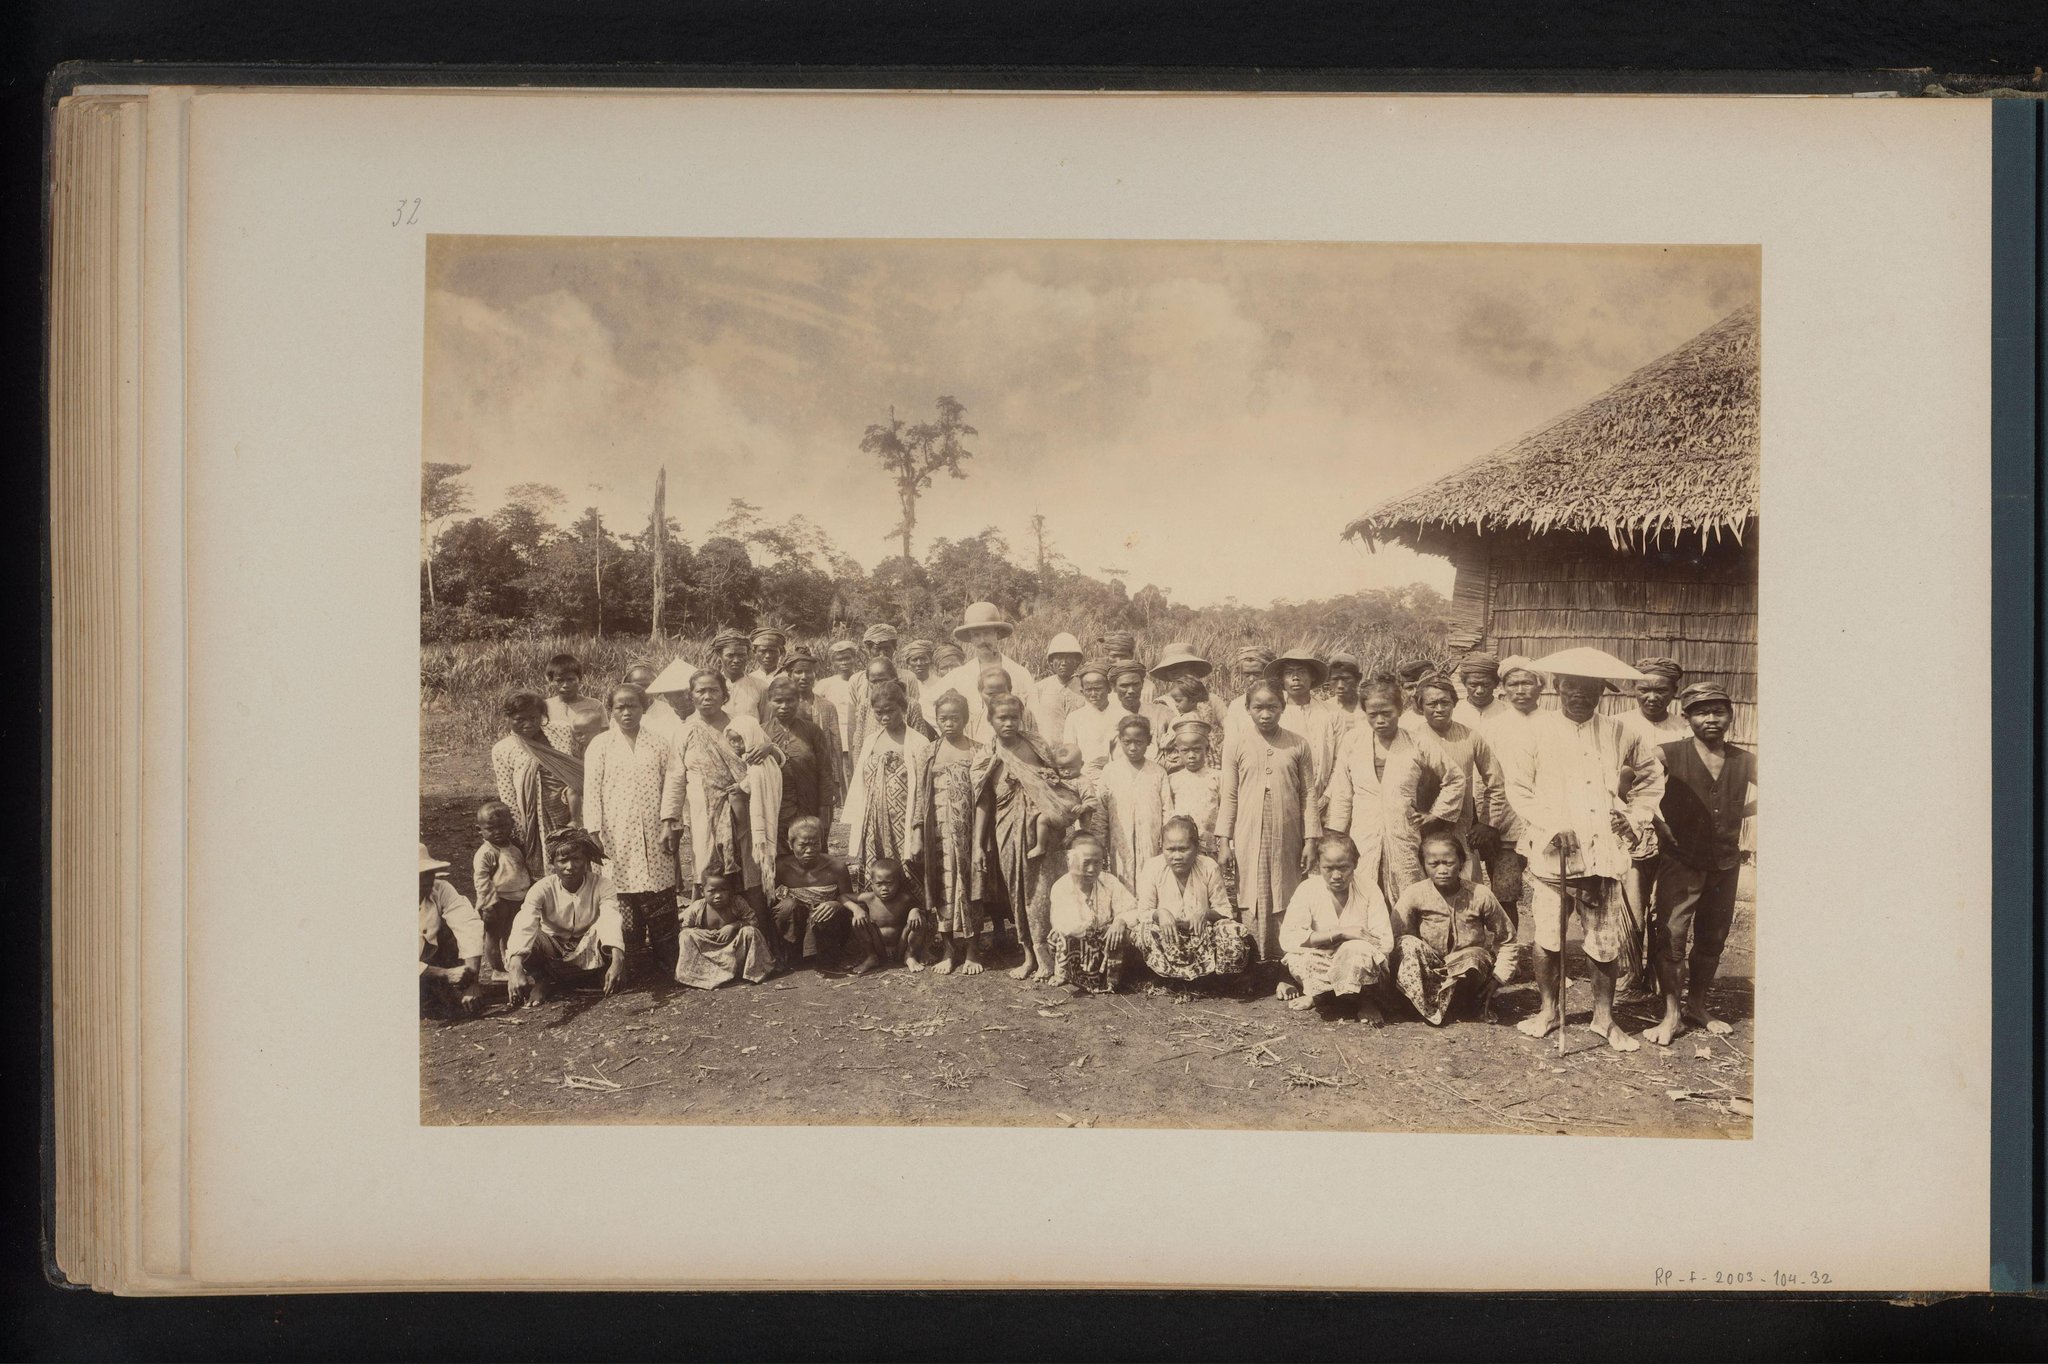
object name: photograph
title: Groepsportret van Javaanse mensen en een Europeaan in Quala Bingei, Sumatra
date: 1890-1900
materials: cardboard, photographic support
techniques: albumen print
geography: sumatra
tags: employer ~ employee, working class, labourers, anonymous historical persons portrayed in a group, in a group-portrait, sumatra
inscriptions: number: ‘32’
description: In de lijst van afbeeldingen wordt deze foto beschreven met de woorden "Javanengruppe, Quala Bingei".